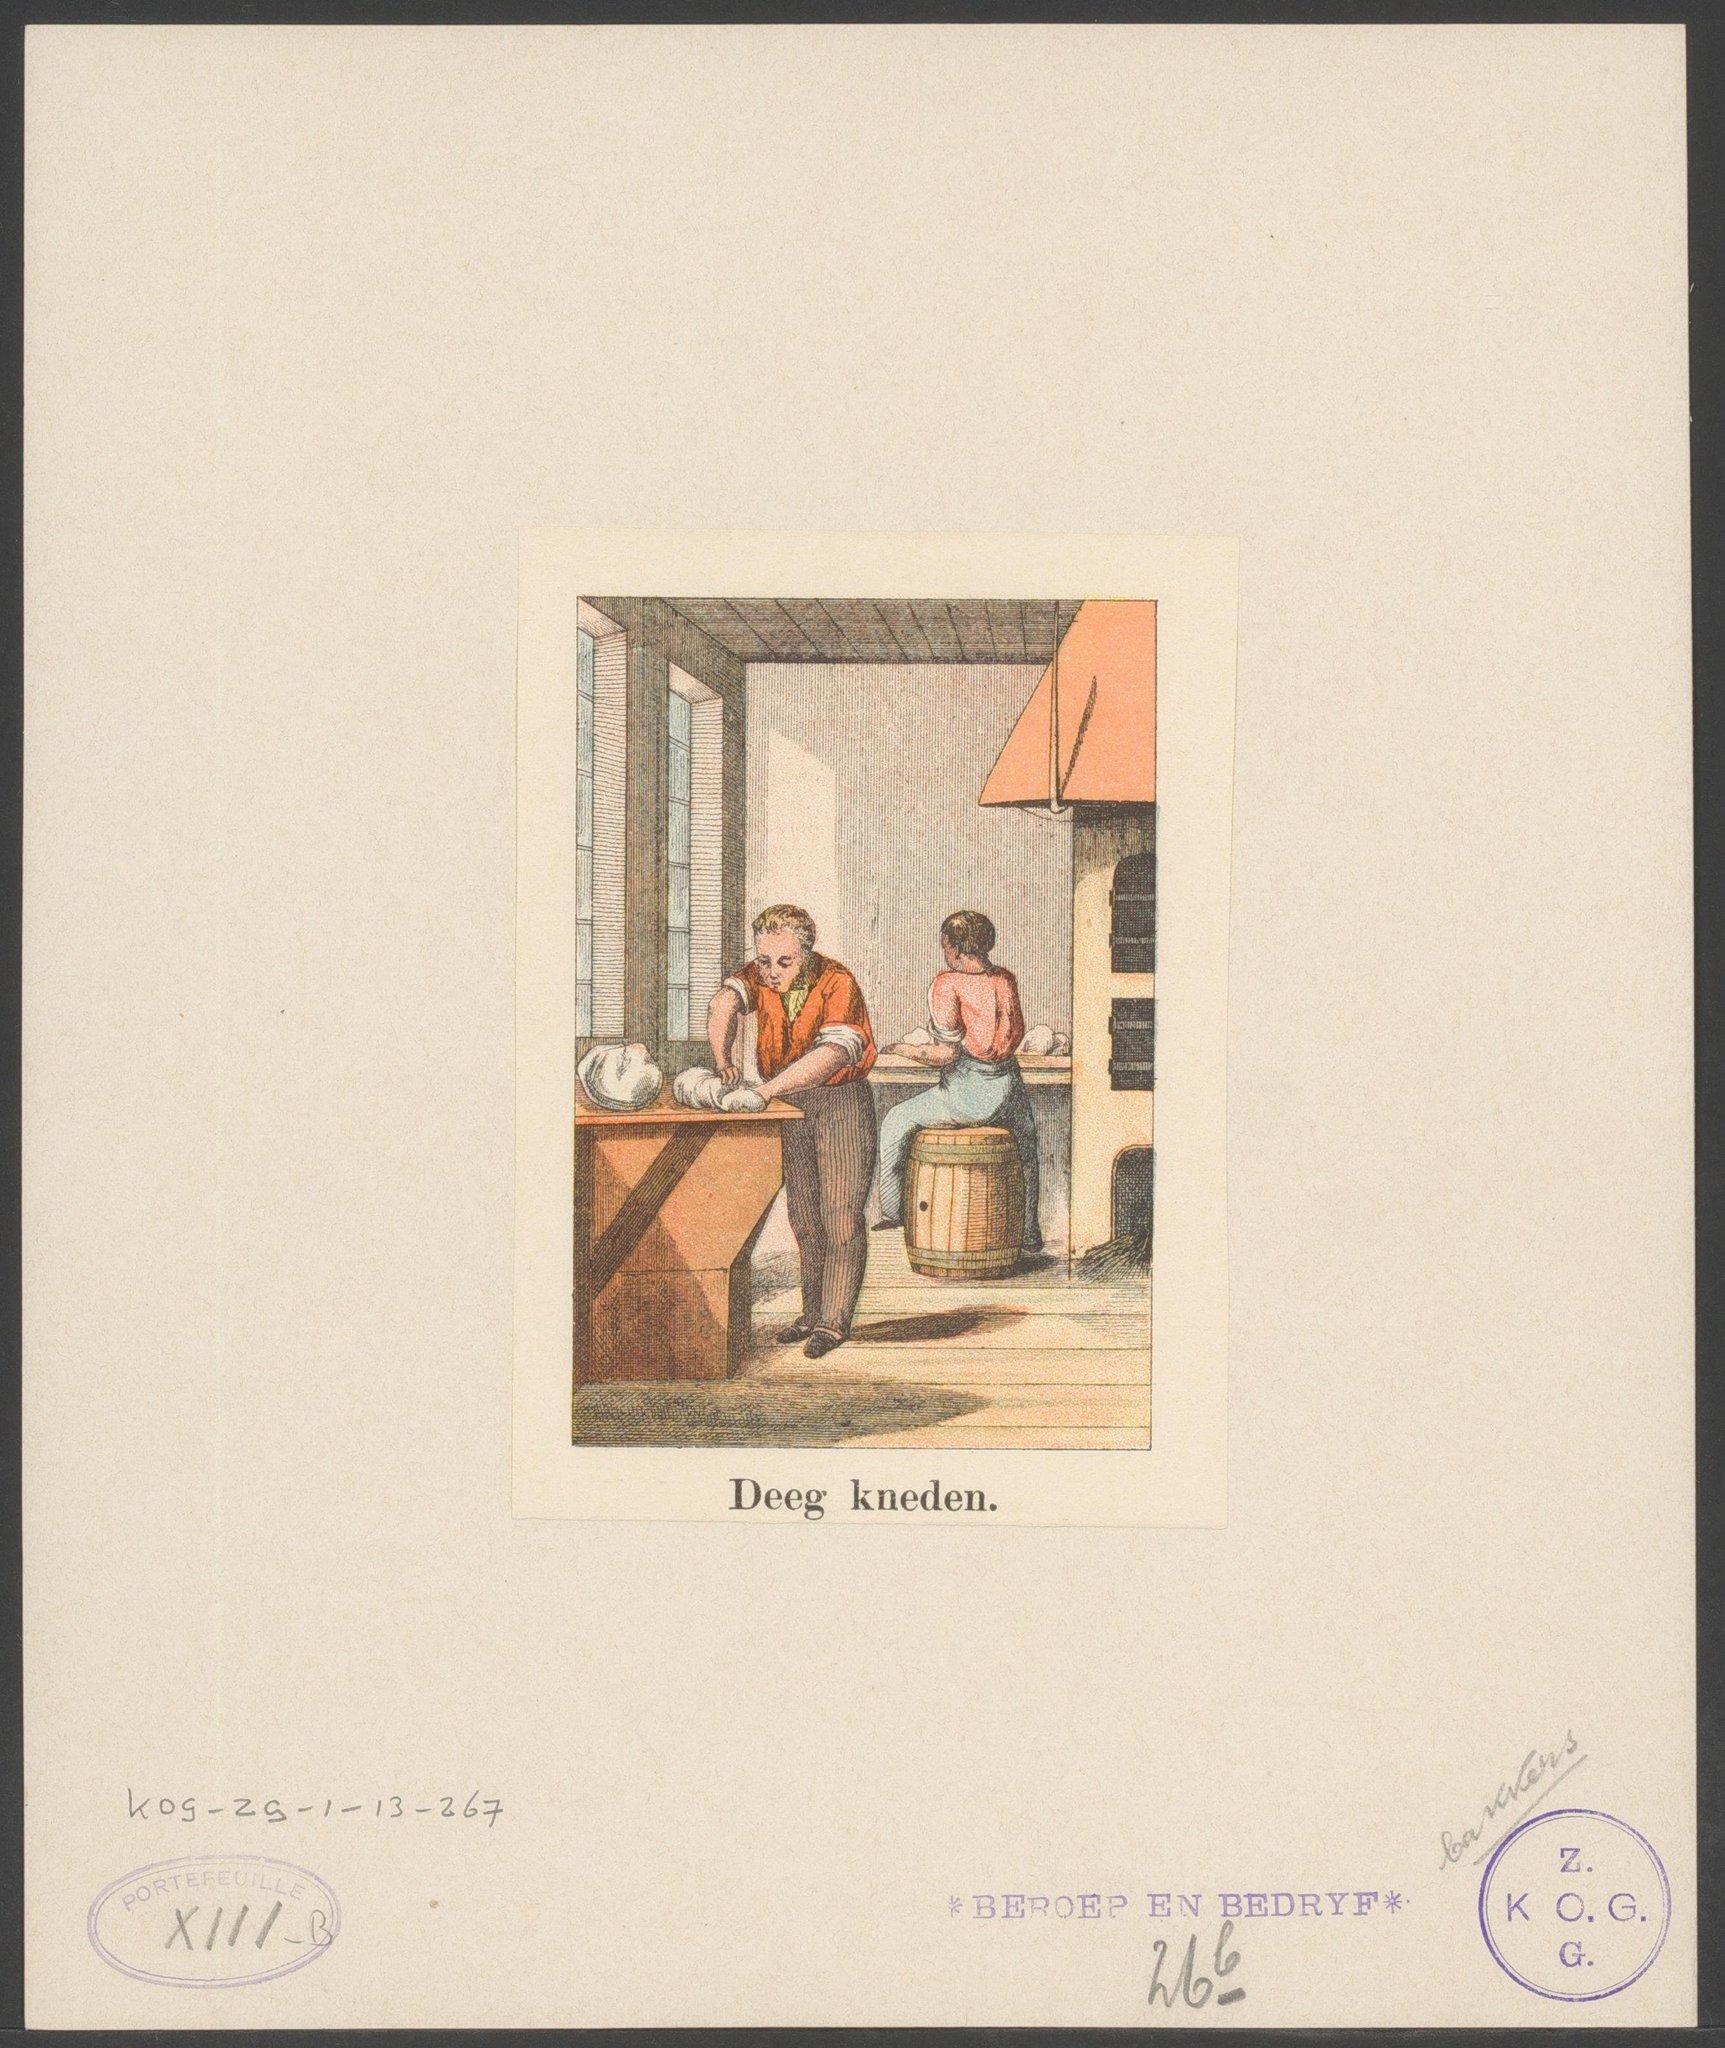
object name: print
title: Deeg kneden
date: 1865-1872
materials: paper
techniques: lithograph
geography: amsterdam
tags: baker (+ labourers ~ crafts, industries, agriculture), baker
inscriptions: collector's mark: Lugt 1641, stamp, stamp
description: Onderwerpsrubrieken binnen de Atlas Zeden en Gewoonten: Handel, Nijverheid en Verkeer, Beroep en bedrijf, Mannelijk, Eet- en drinkwaren.